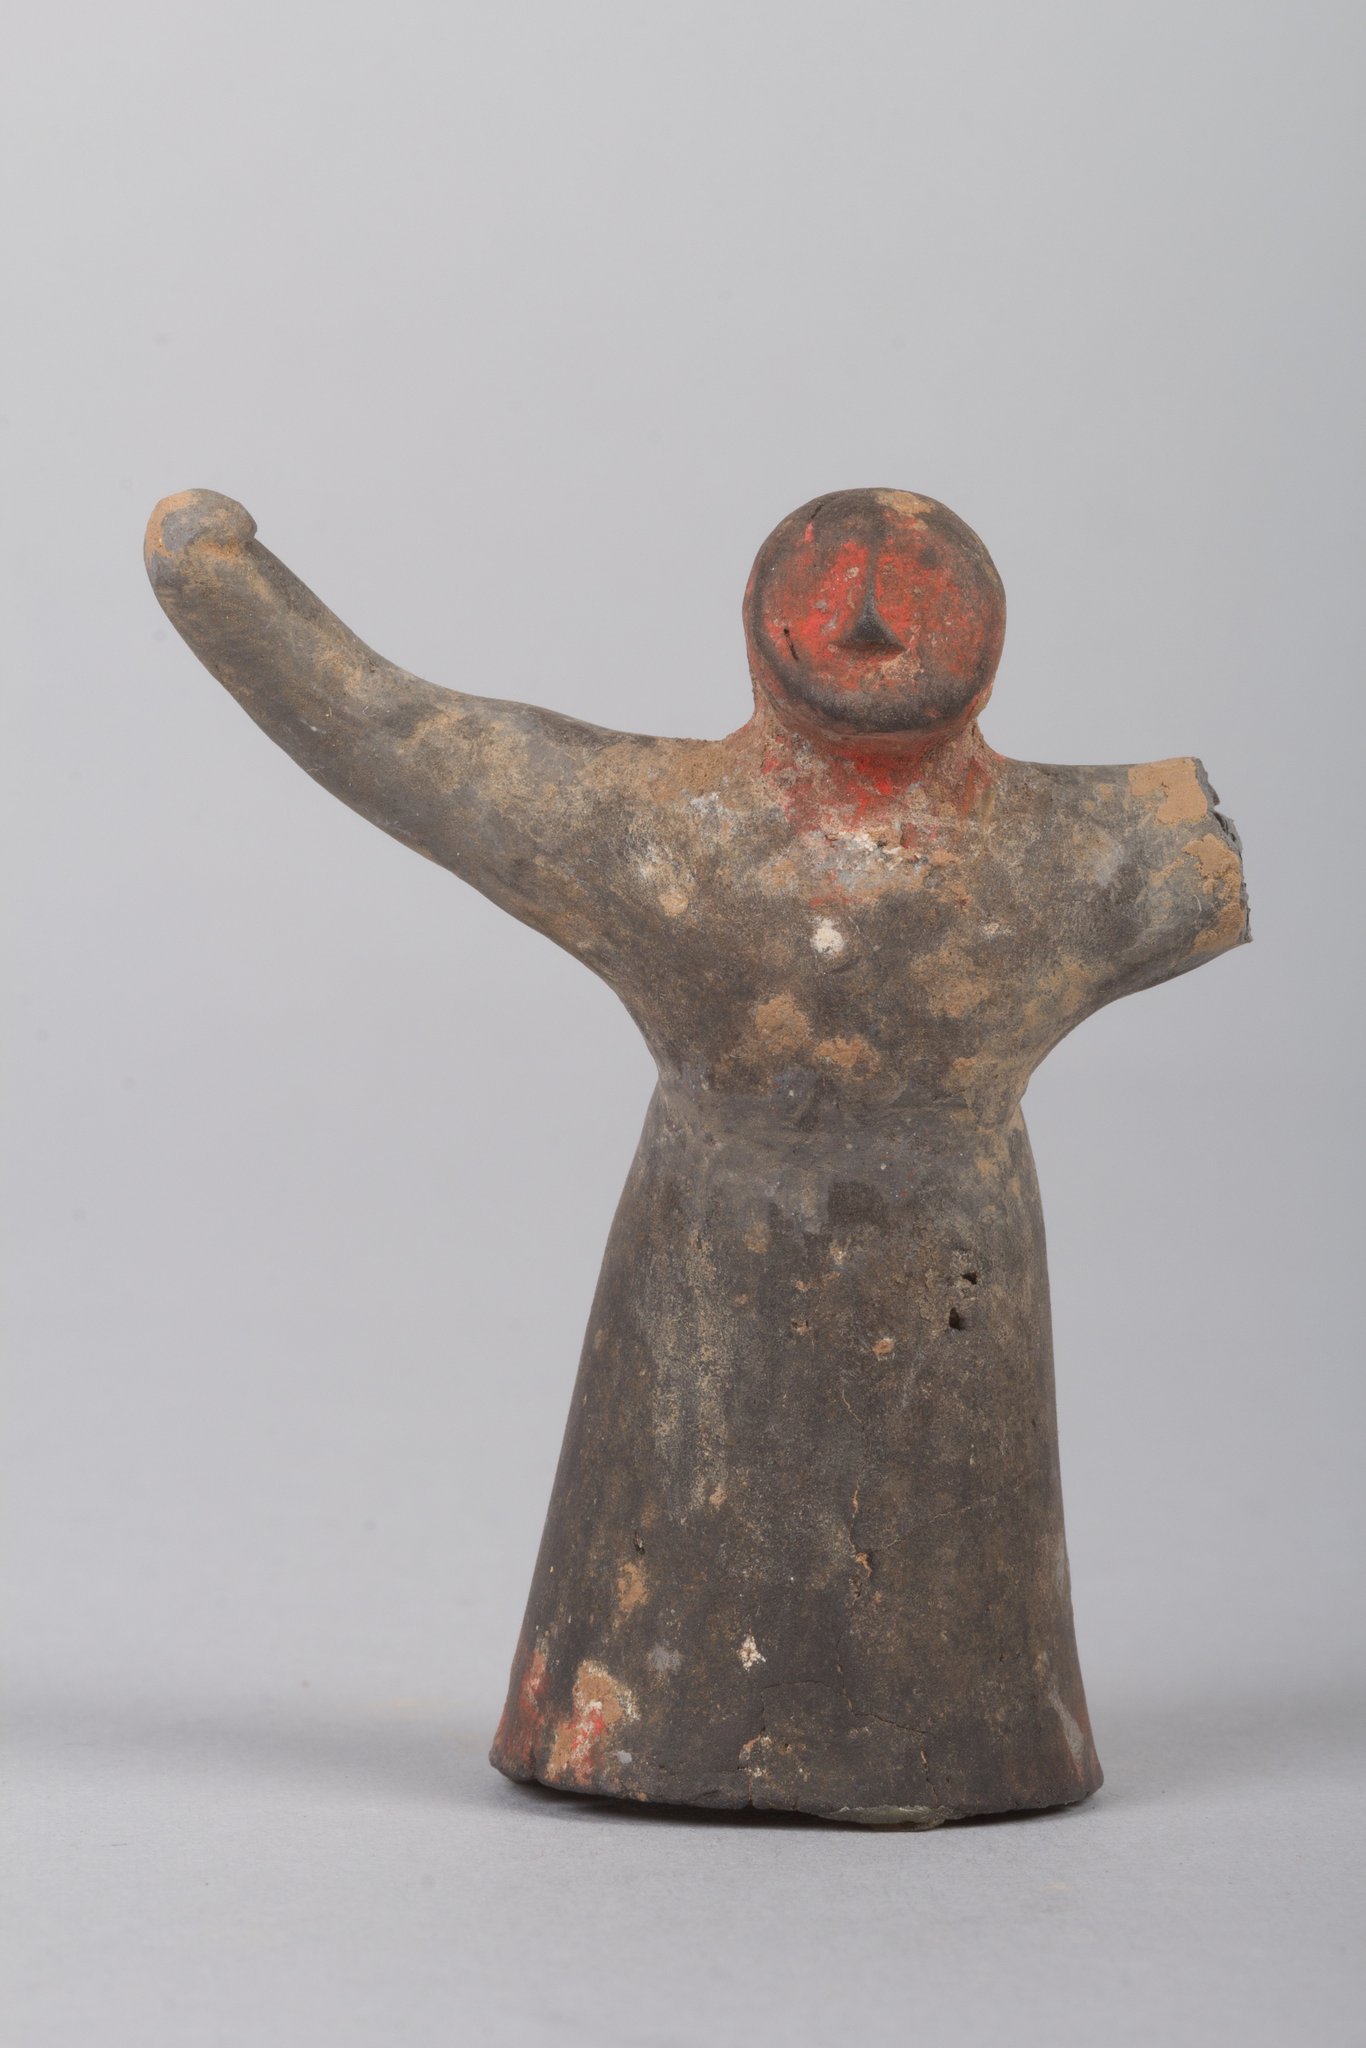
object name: figure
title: Figure of a woman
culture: chinese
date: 400-201 BCE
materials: clay